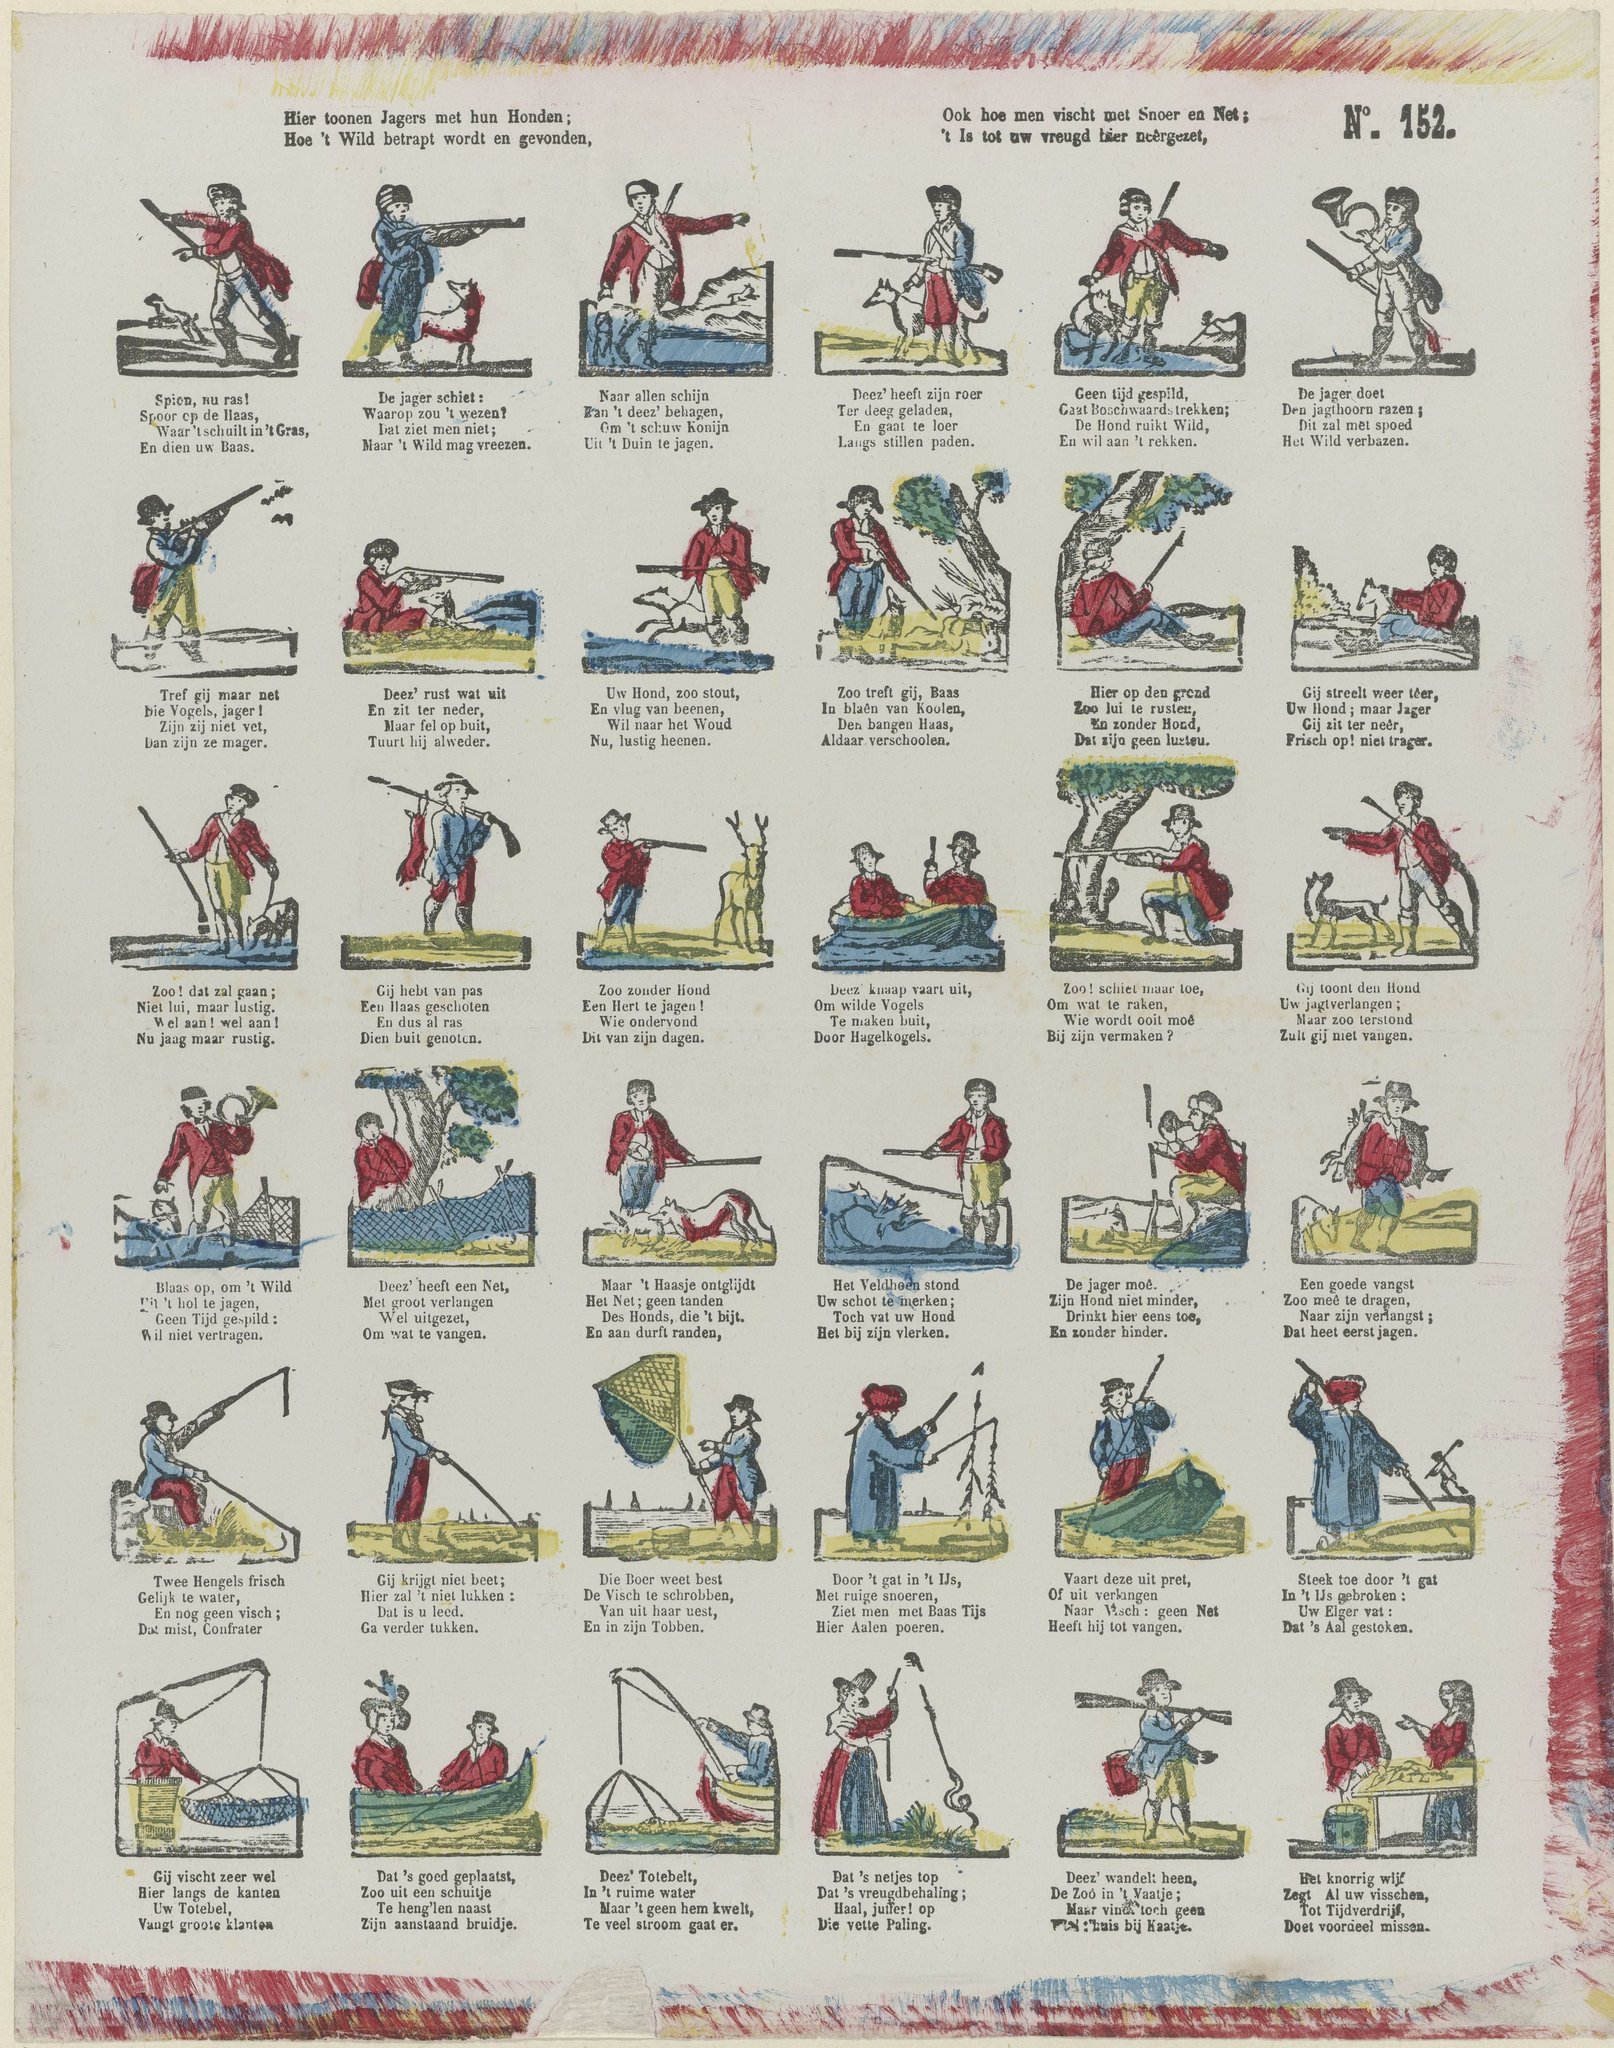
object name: popular print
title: Hier toonen jagers met hun honden; / hoe 't wild betrapt wordt en gevonden, / Ook hoe men vischt met snoer en net; / 't is tot uw vreugd hier neêrgezet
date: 1827-1894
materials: paper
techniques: colour, letterpress printing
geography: schaarbeek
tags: hunting, chase, hunter, fishing (sports), fisherman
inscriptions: collector's mark: Lugt 2760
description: Blad met 36 voorstellingen van jagers en vissers. Onder elke voorstelling een vierregelig vers. Genummerd rechtsboven: No. 152.